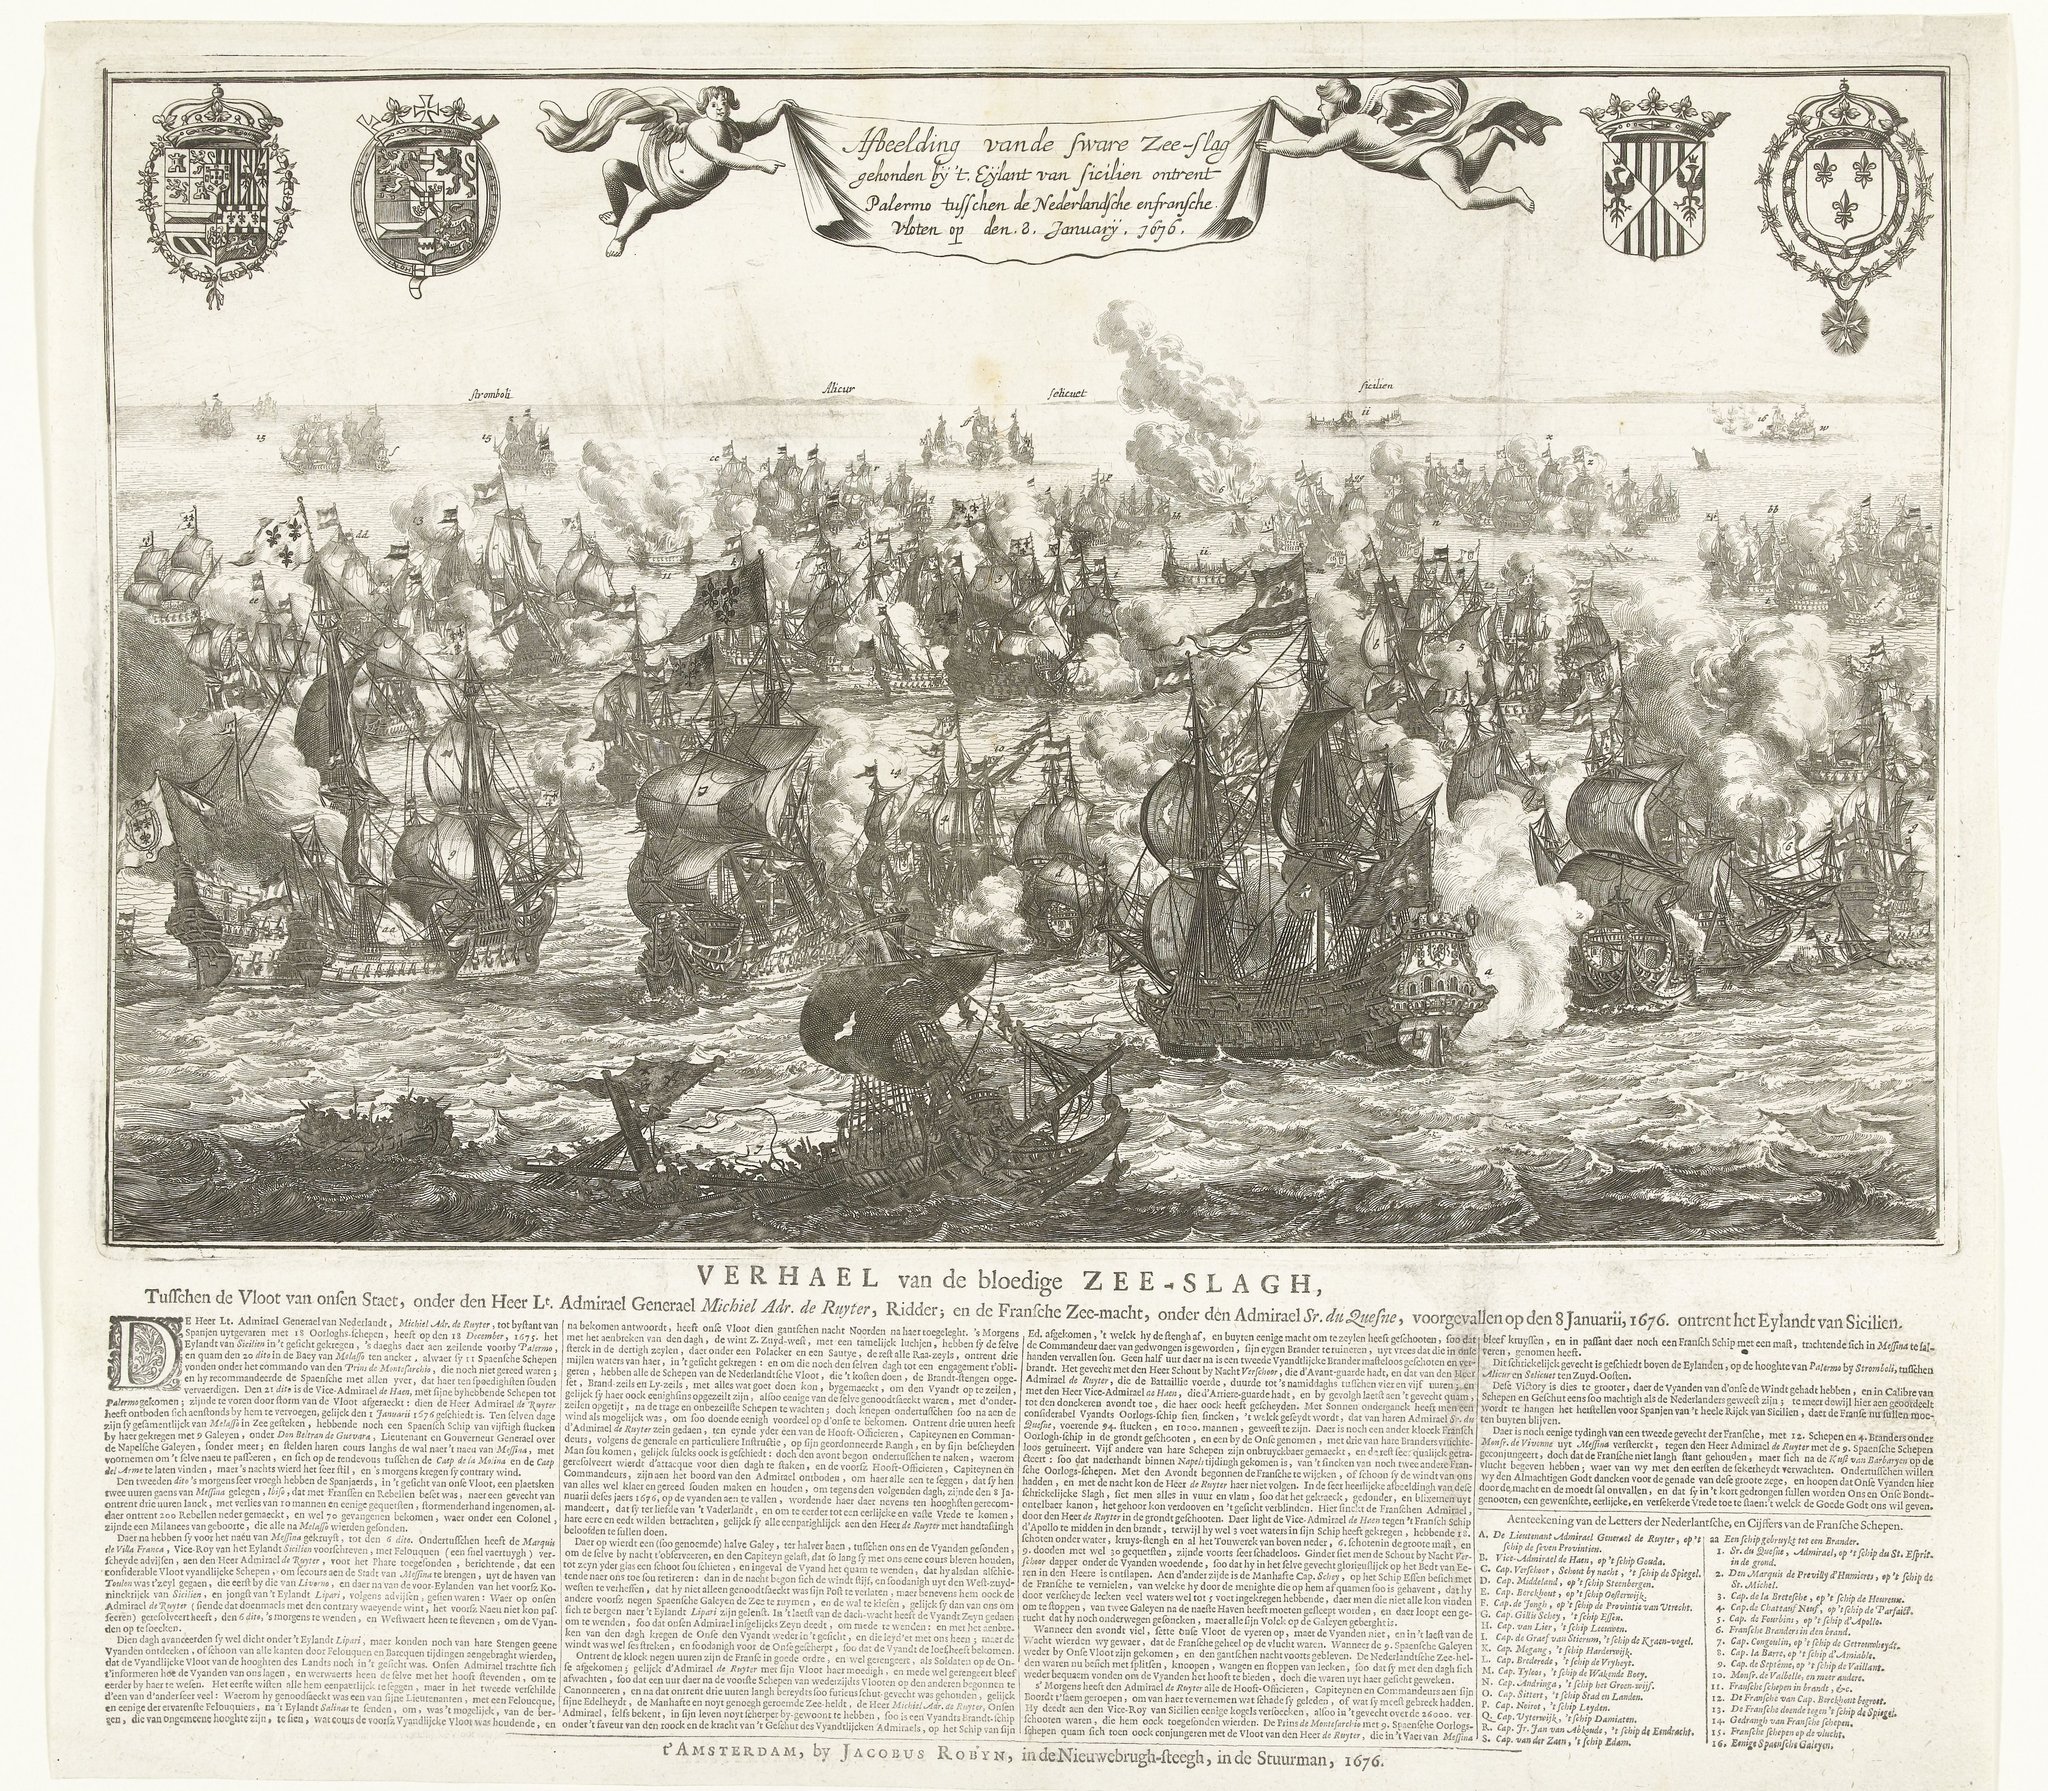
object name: print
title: Afbeelding vande sware Zee-slag gehouden by 't Eylant van sicilien ontrent Palermo tusschen de Nederlandsche en fransche vloten op den 8. January. 1676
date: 1673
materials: paper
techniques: engraving, etching, letterpress printing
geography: amsterdam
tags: flushing, michiel adriaenszoon de ruyter, william iii (prince of orange and king of england, scotland, and ireland), paris, battle (+ naval force), battle of stromboli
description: Zeeslag bij Stromboli op 8 januari 1676 tussen de vloot van de Republiek onder Michiel Adriaenszoon de Ruyter en een Franse vloot onder Abraham Duquesne. Bovenaan de wapens van de Spaanse koning Karel II, prins Willem III en Frankrijk. Gedrukt onder de plaat een tekst in 4 kolommen met de legenda's A-S en 1-16 in het Nederlands.